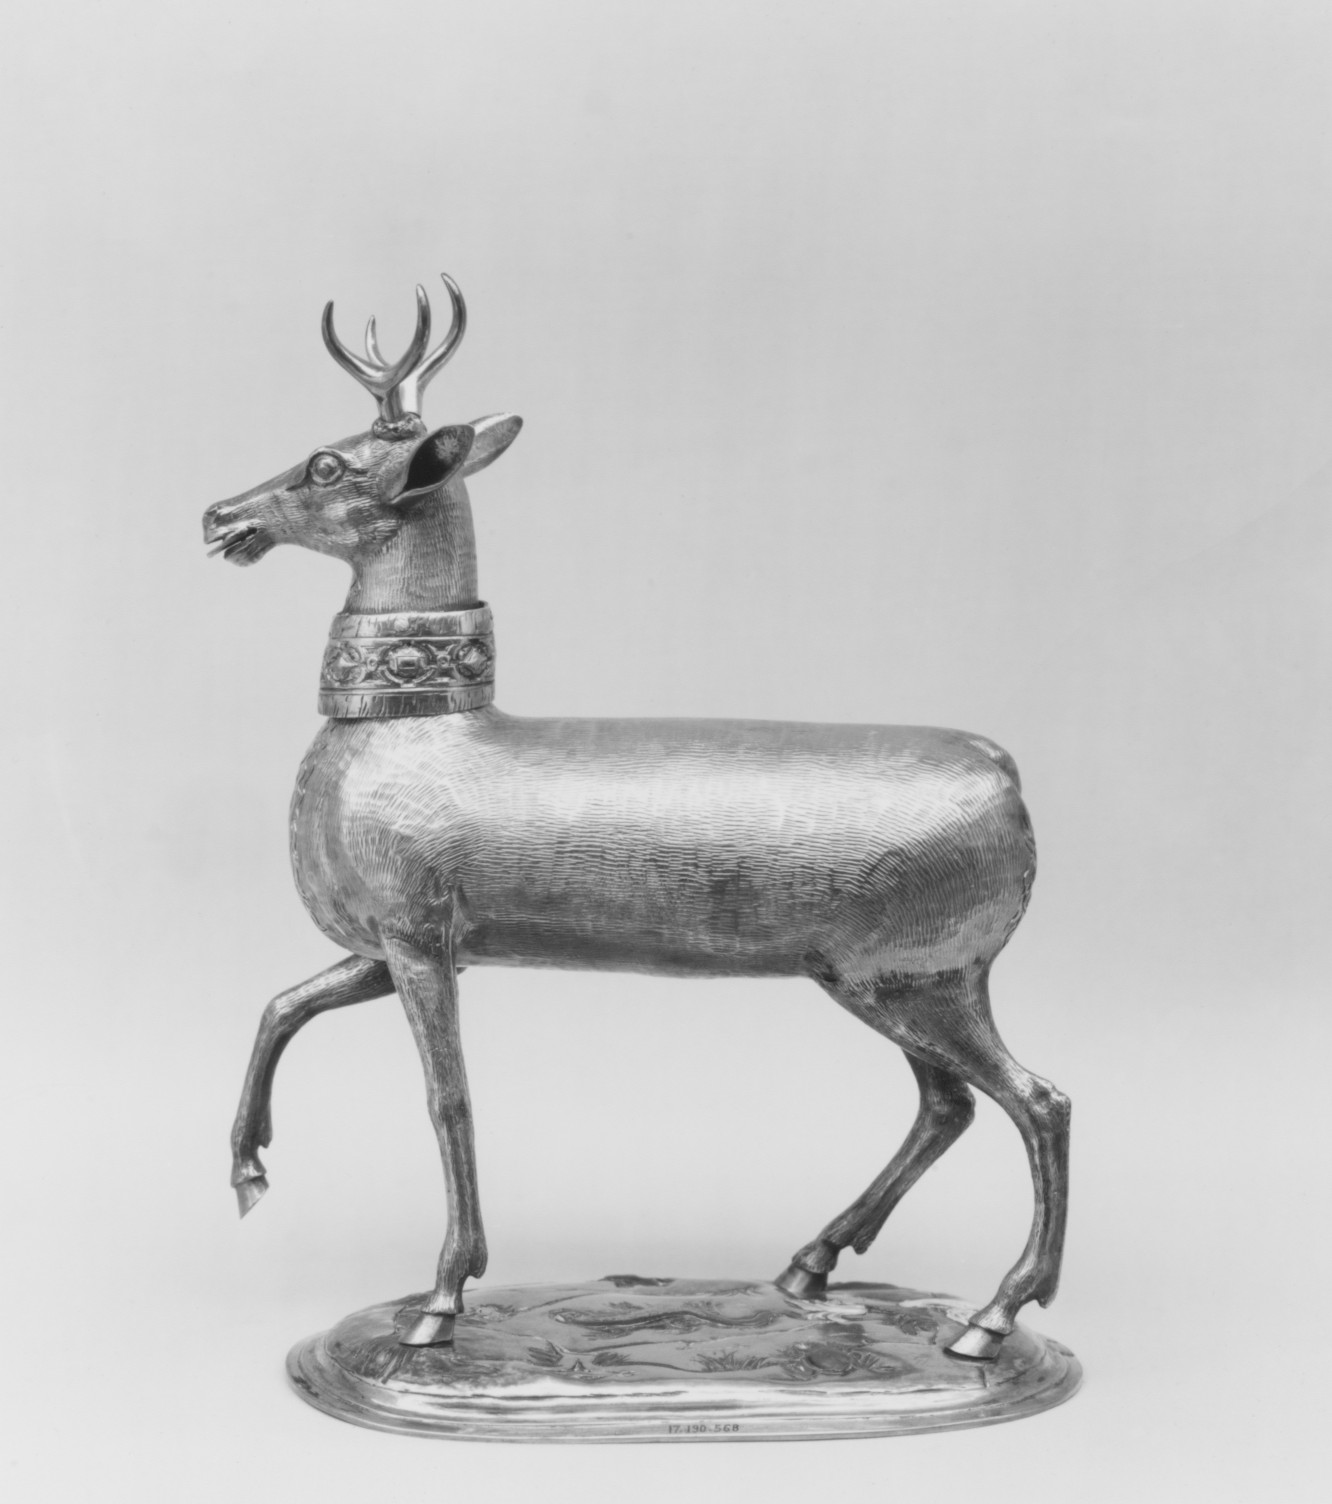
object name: cup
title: Cup in the form of a stag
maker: christoph beham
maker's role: maker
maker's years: 1510-1610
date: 1601-1633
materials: enamel, gilt, silver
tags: deer